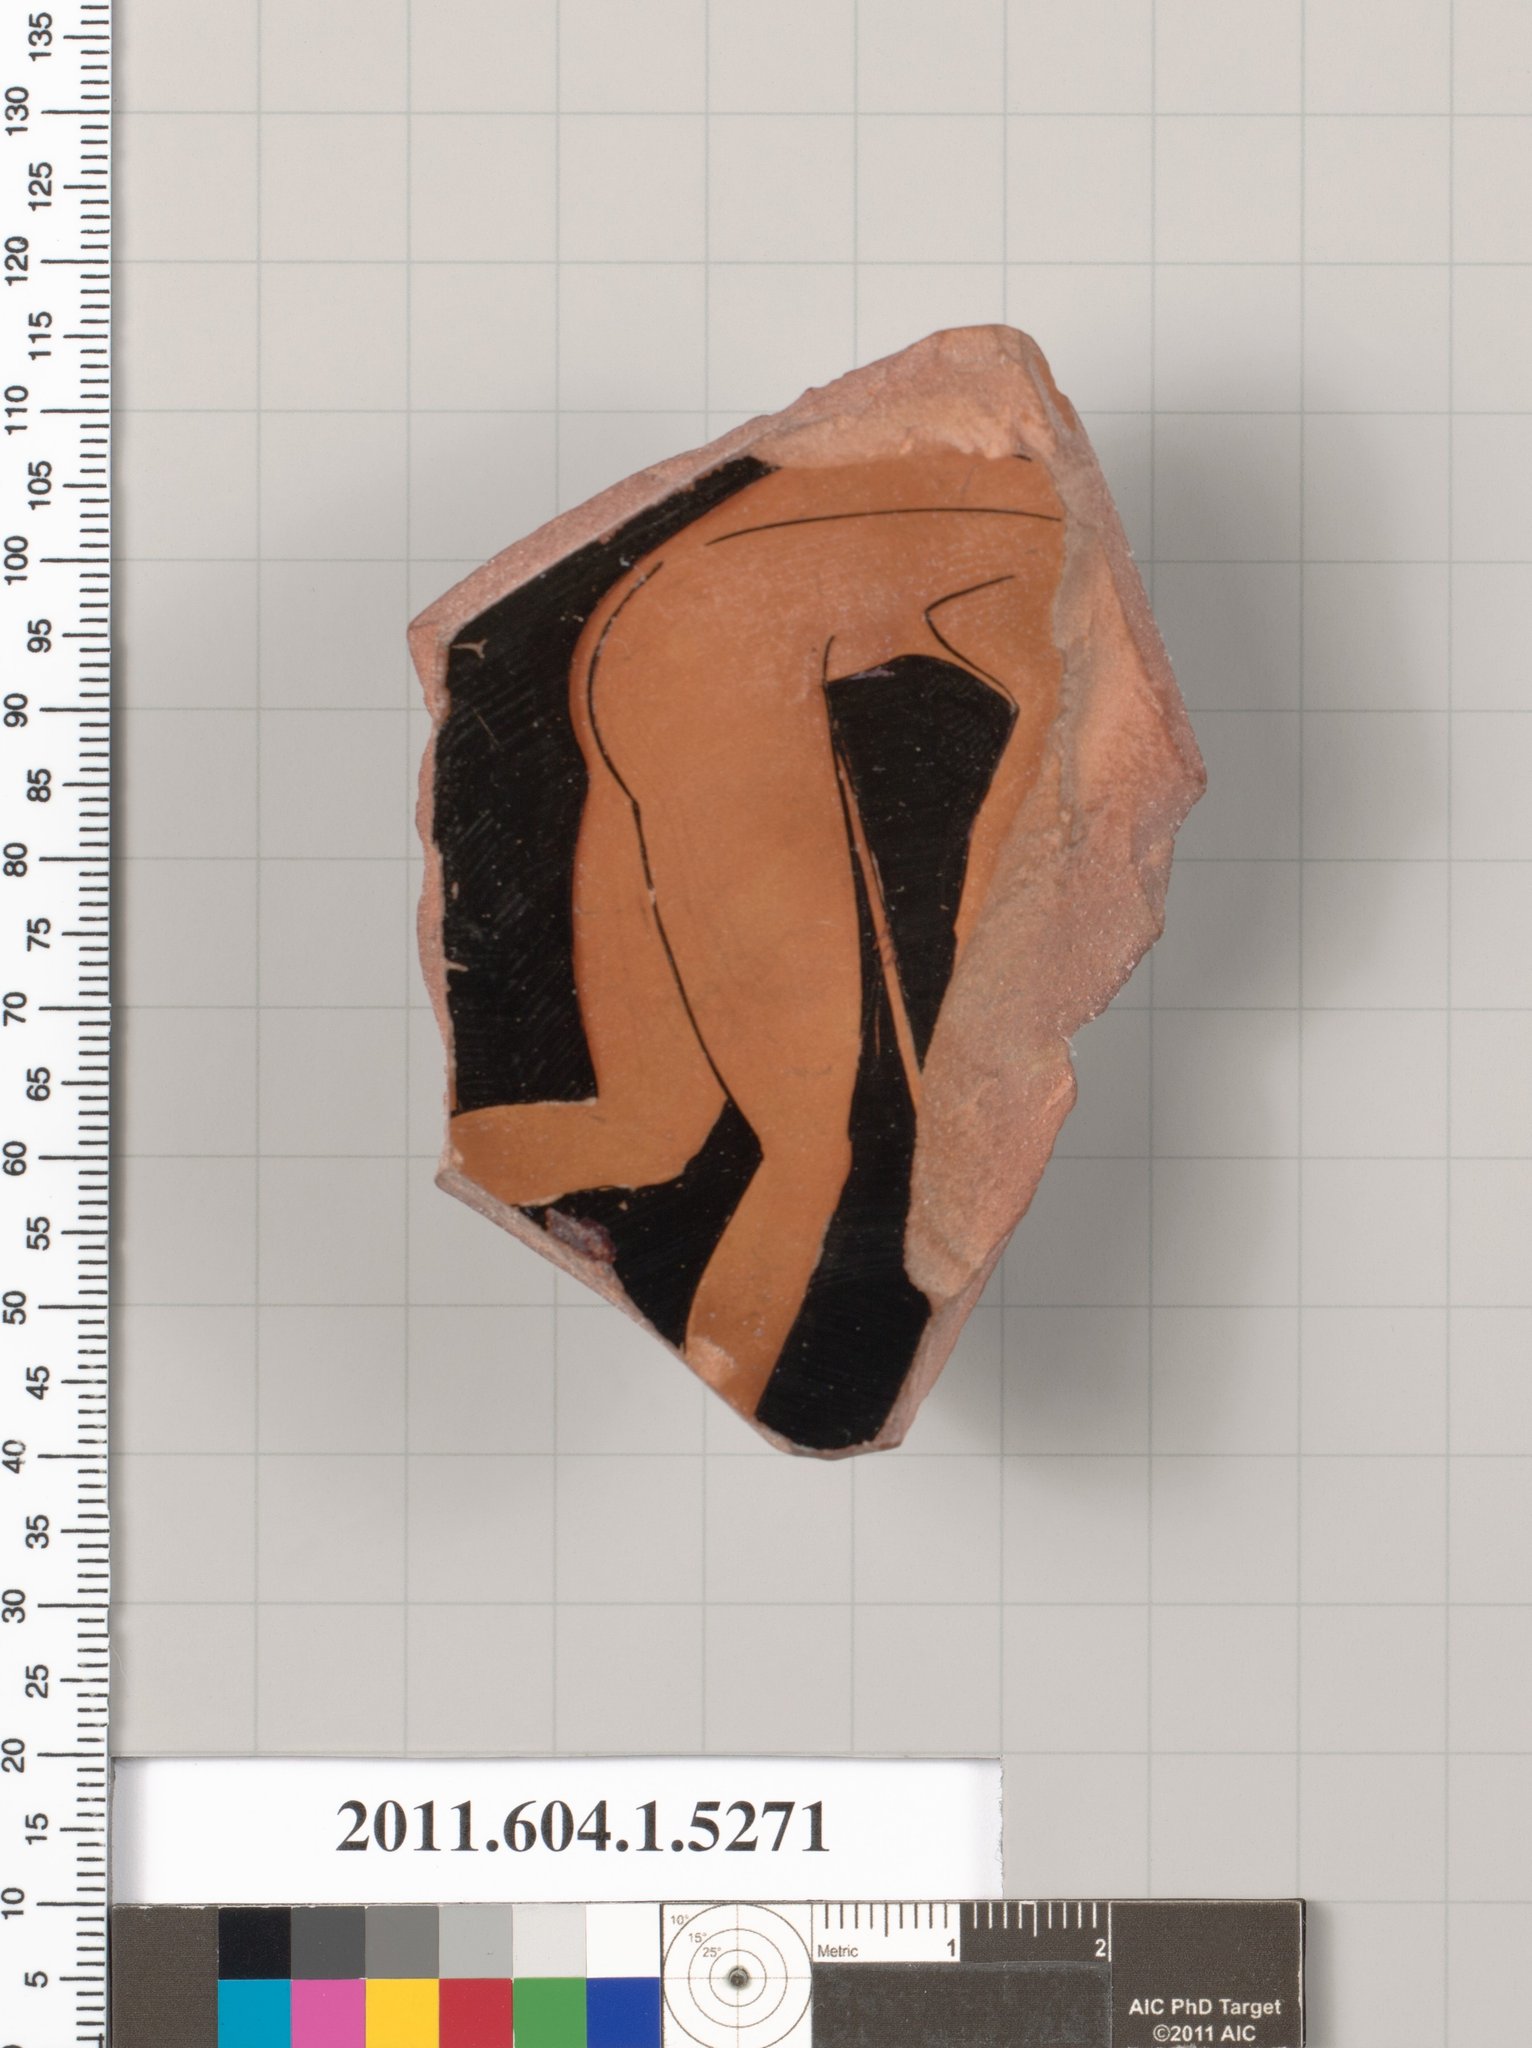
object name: kylix fragment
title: Terracotta fragment of a kylix (drinking cup)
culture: greek, attic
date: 500-480 BCE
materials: terracotta